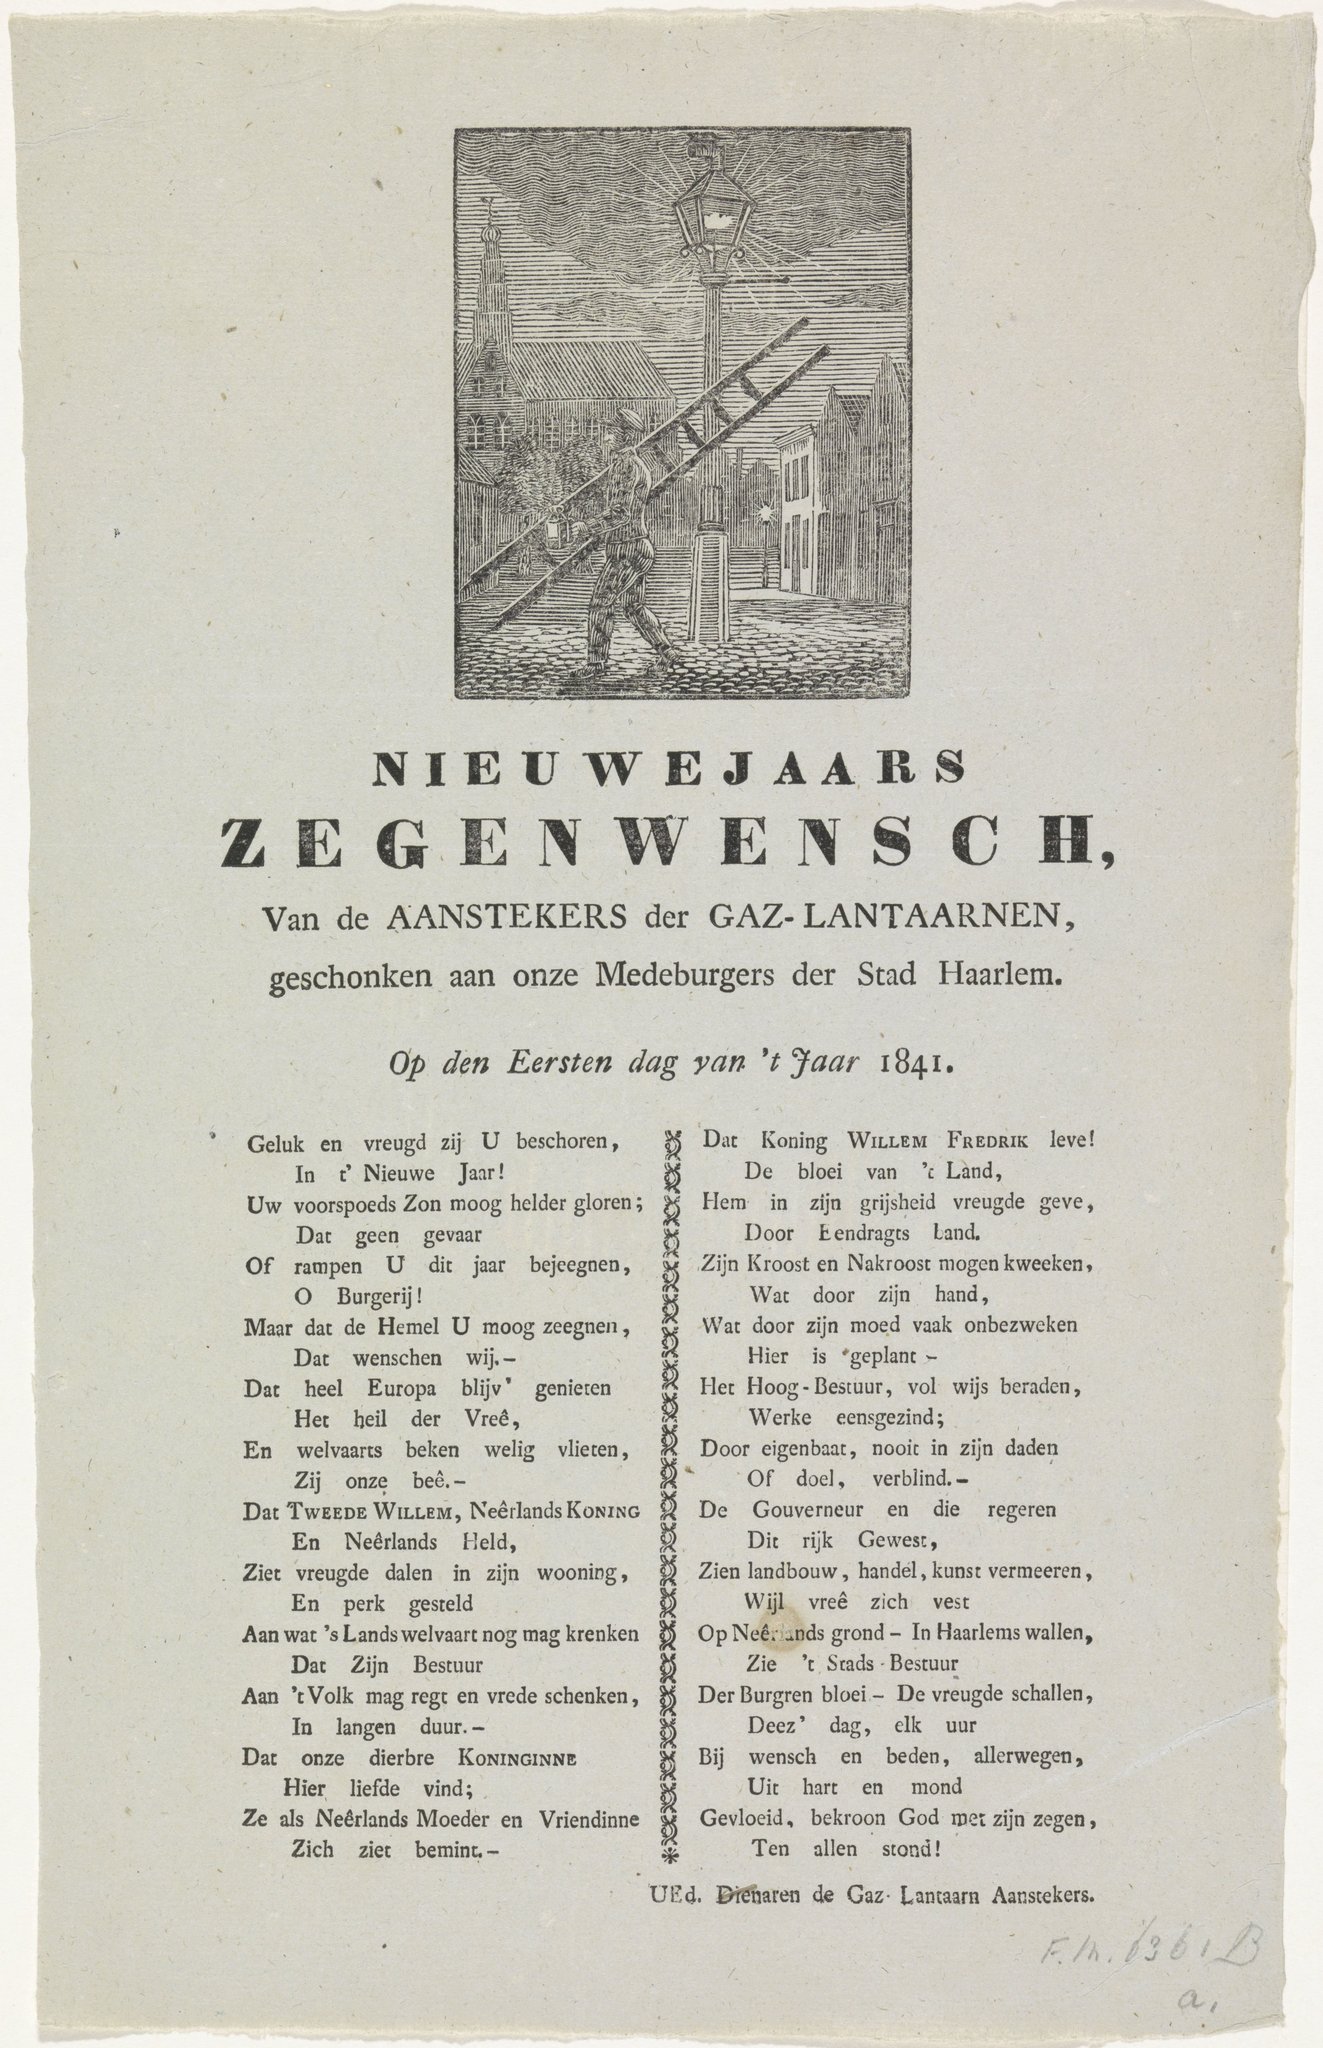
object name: new year card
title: Nieuwjaars Zegenwensch, van de Aanstekers der Gaz-Lantaarnen (...) 1841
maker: Anonymous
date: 1840-1841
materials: paper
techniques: letterpress printing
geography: haarlem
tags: gas-lamp (+ kindling a light; lit, burning light, lamp, candle), street lighting, street, haarlem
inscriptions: collector's mark: Lugt 2228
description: Nieuwjaarswens van de Haarlemse gaslantaarnopstekers voor het jaar 1841. Een lantaarnopsteker loopt met een ladder op de schouder langs een brandende straatlantaarn. Op de achtergrond de Sint-Bavo te Haarlem. Met een vers in twee kolommen.